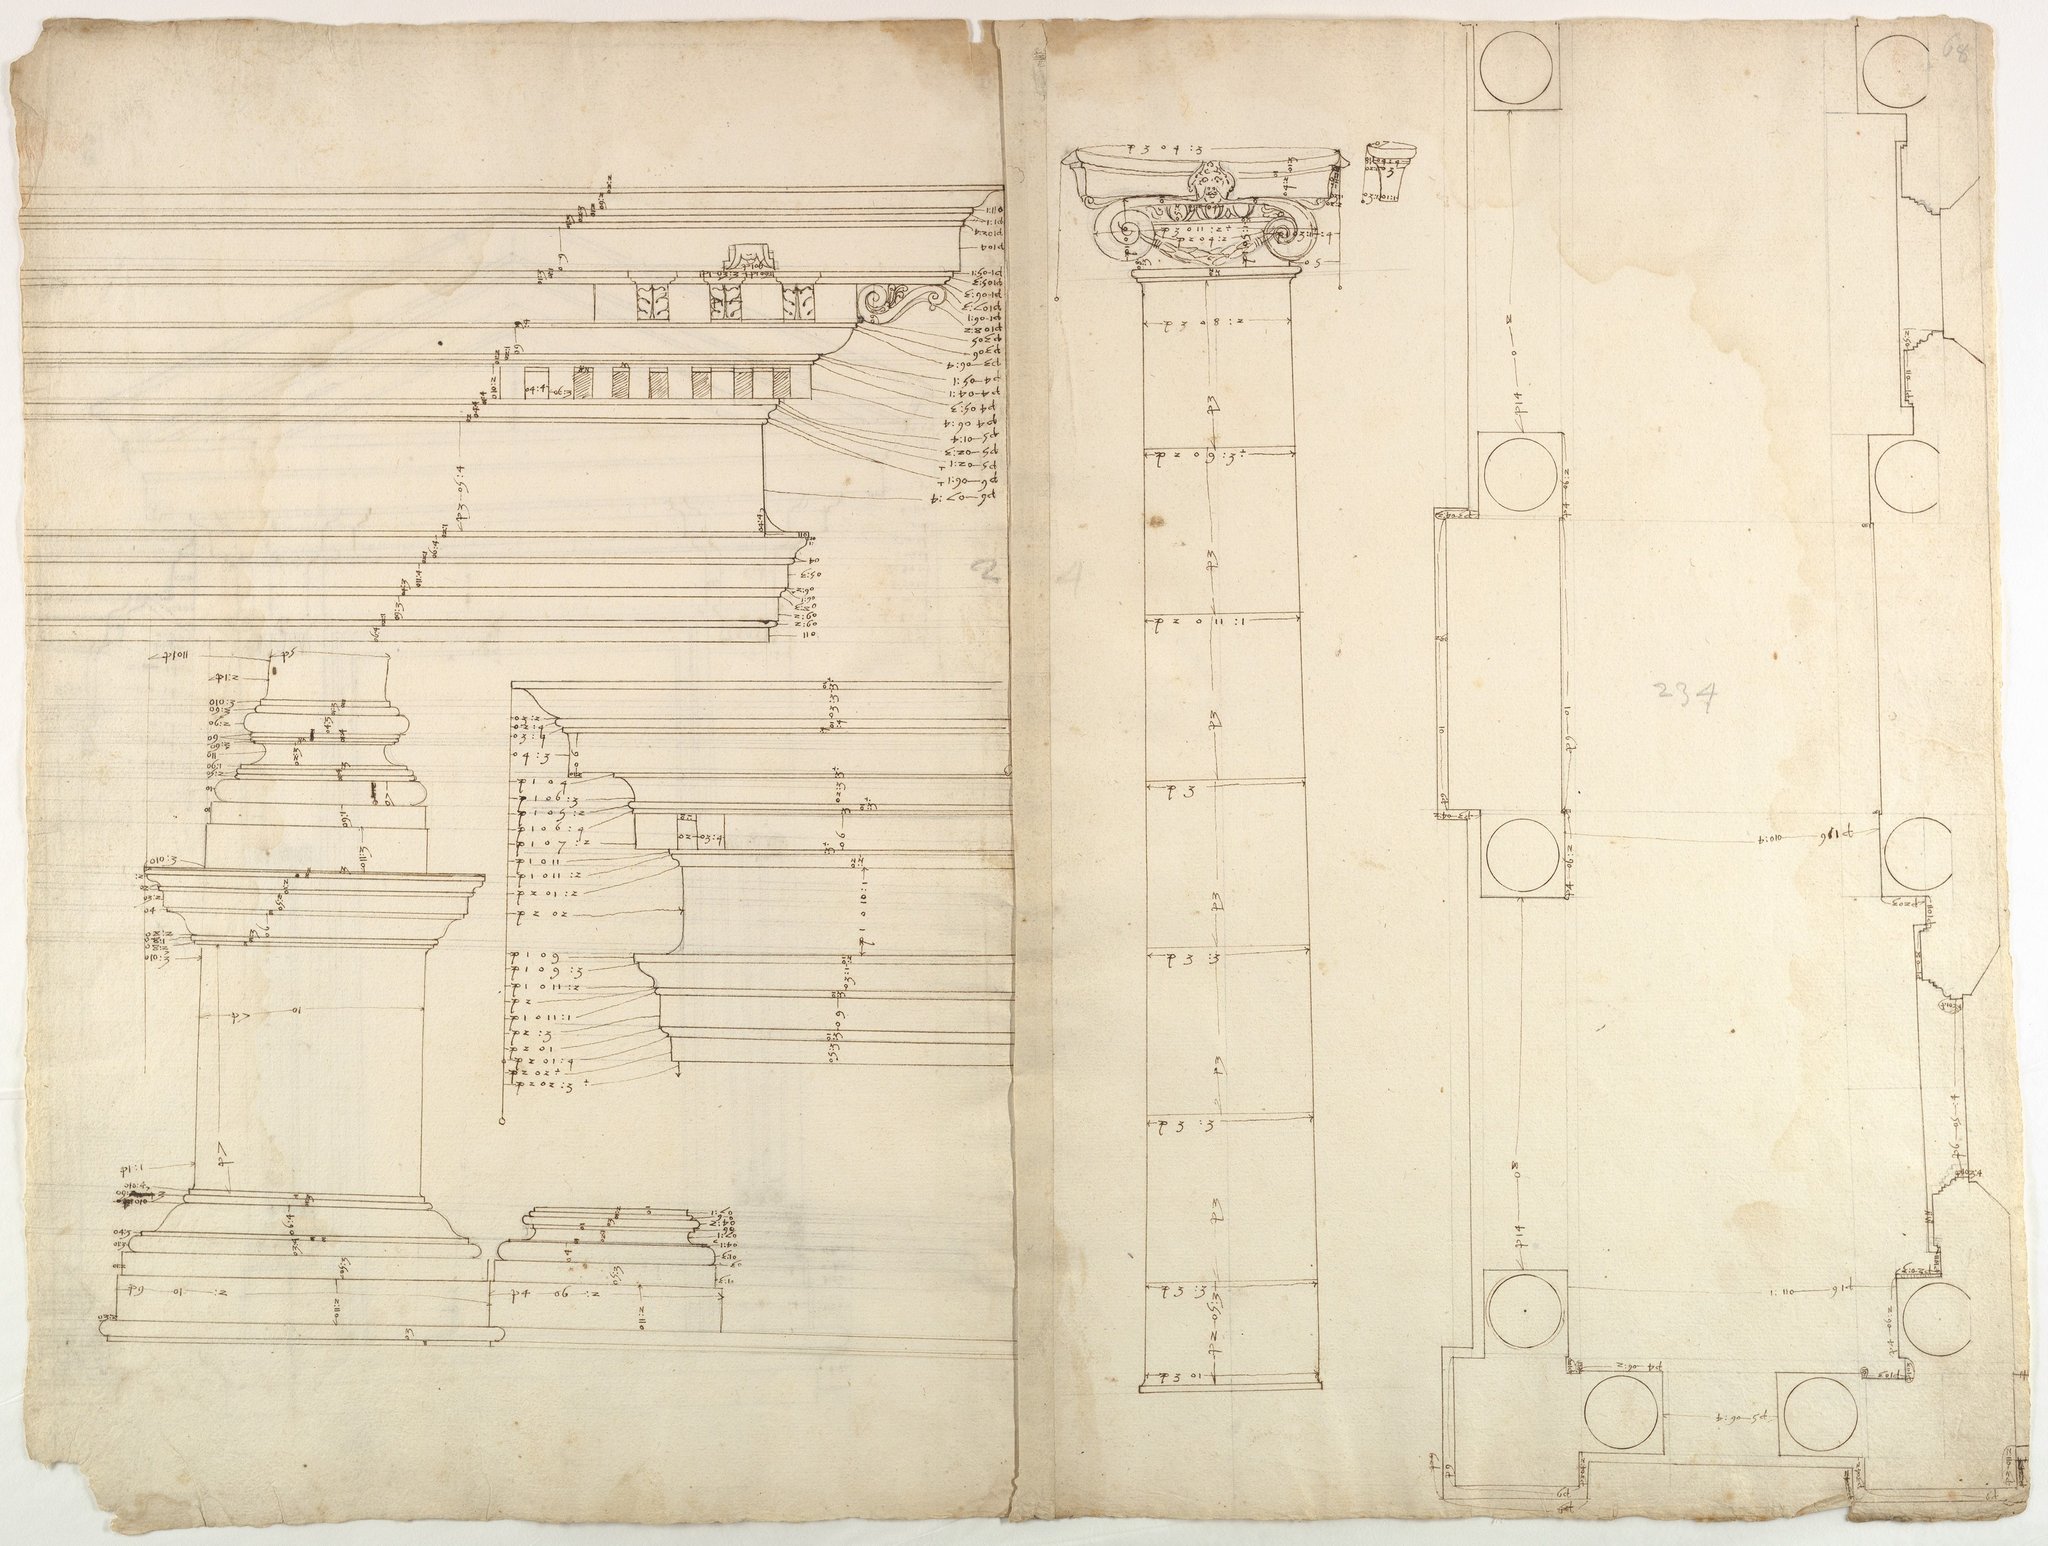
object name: drawing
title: Palazzo dei Conservatori, portico, plan; façade cornice, elevation; minor order, cornice; column, elevation; pedestal, elevation (recto); Palazzo dei Conservatori, portal, elevation; section (verso)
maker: anonymous, french, 16th century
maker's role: draftsman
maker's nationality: french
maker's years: 1500-1600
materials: chalk, ink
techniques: incising, pen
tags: architecture,columns